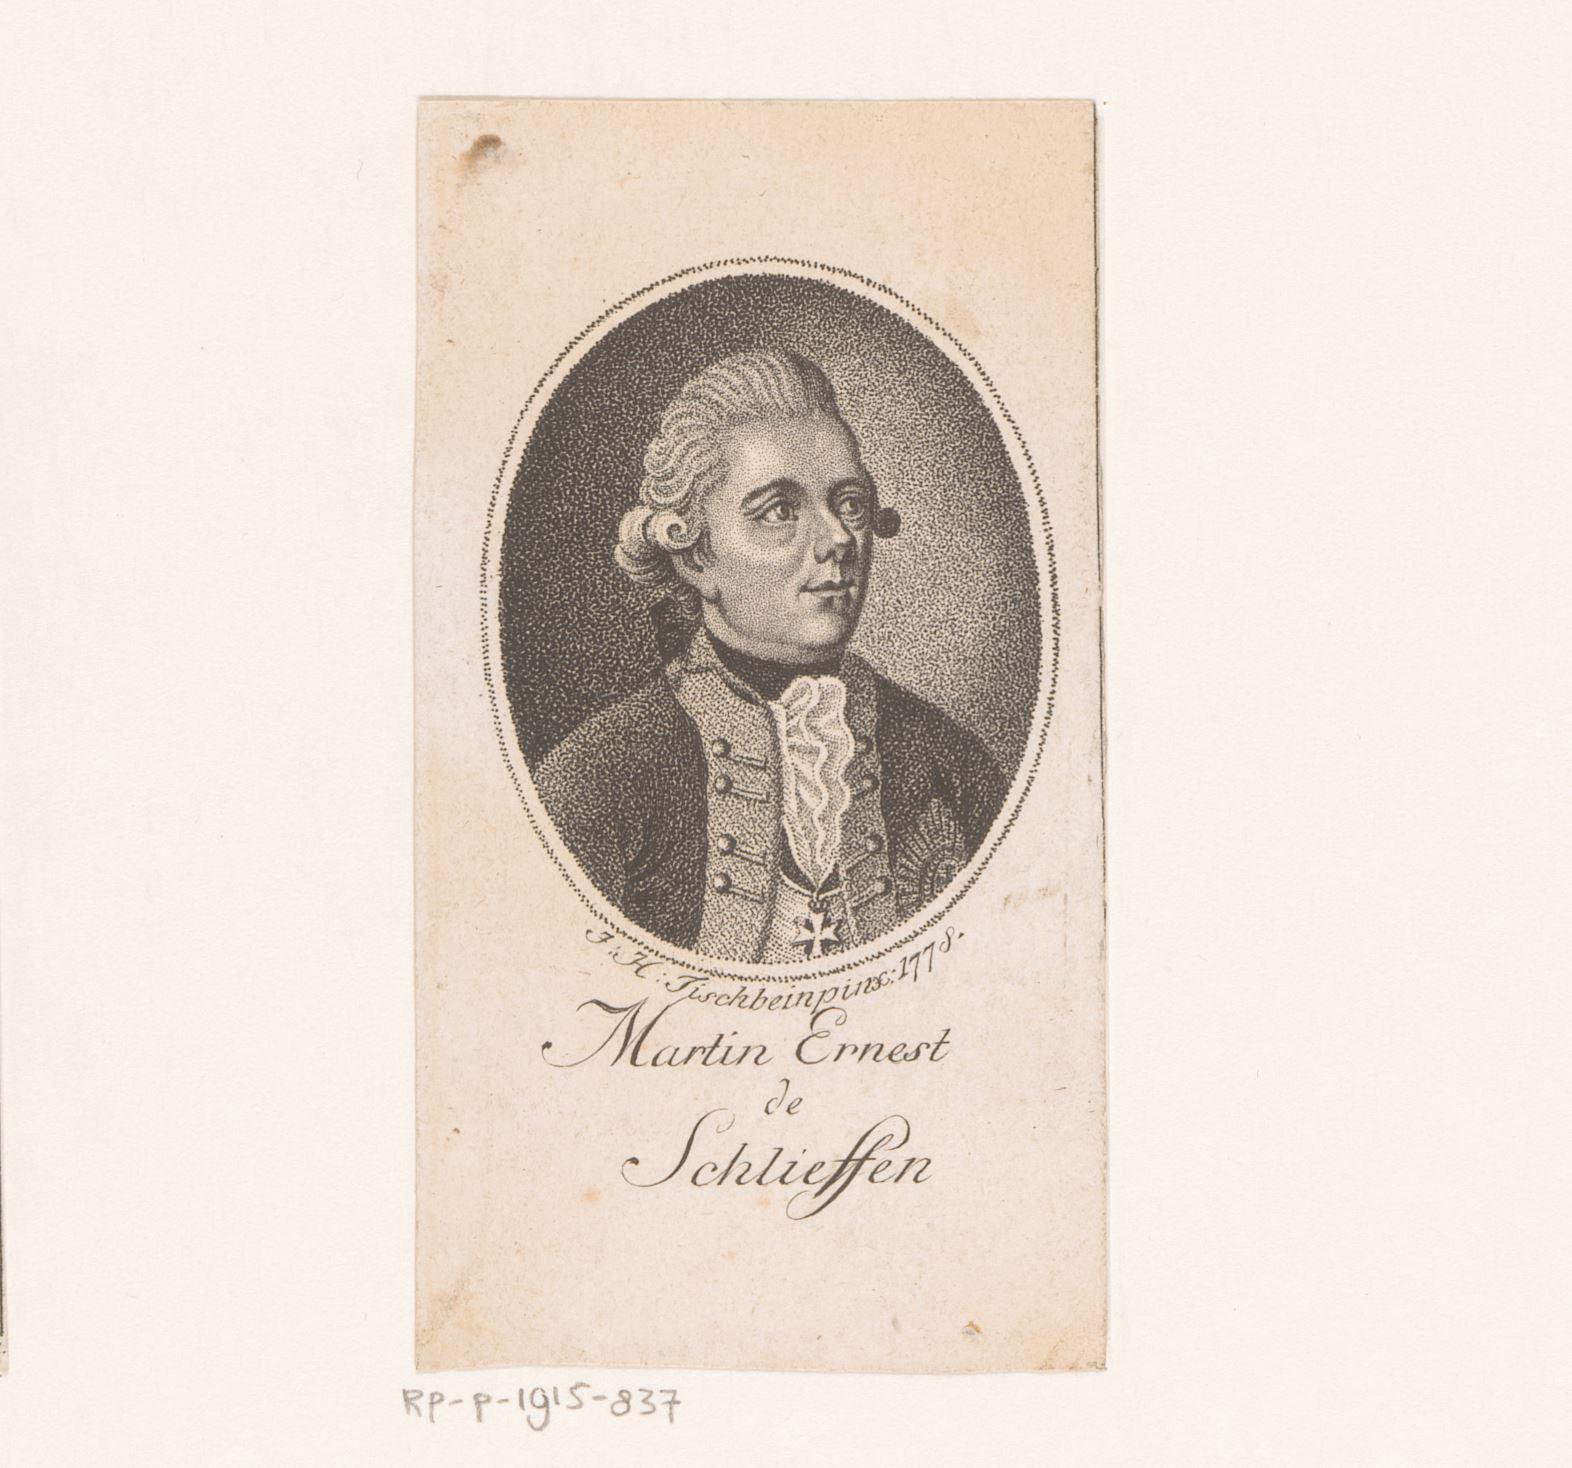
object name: print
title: Portret van Martin Ernst von Schlieffen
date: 1778-1810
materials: paper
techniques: engraving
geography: germany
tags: historical persons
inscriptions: collector's mark: Lugt 2228